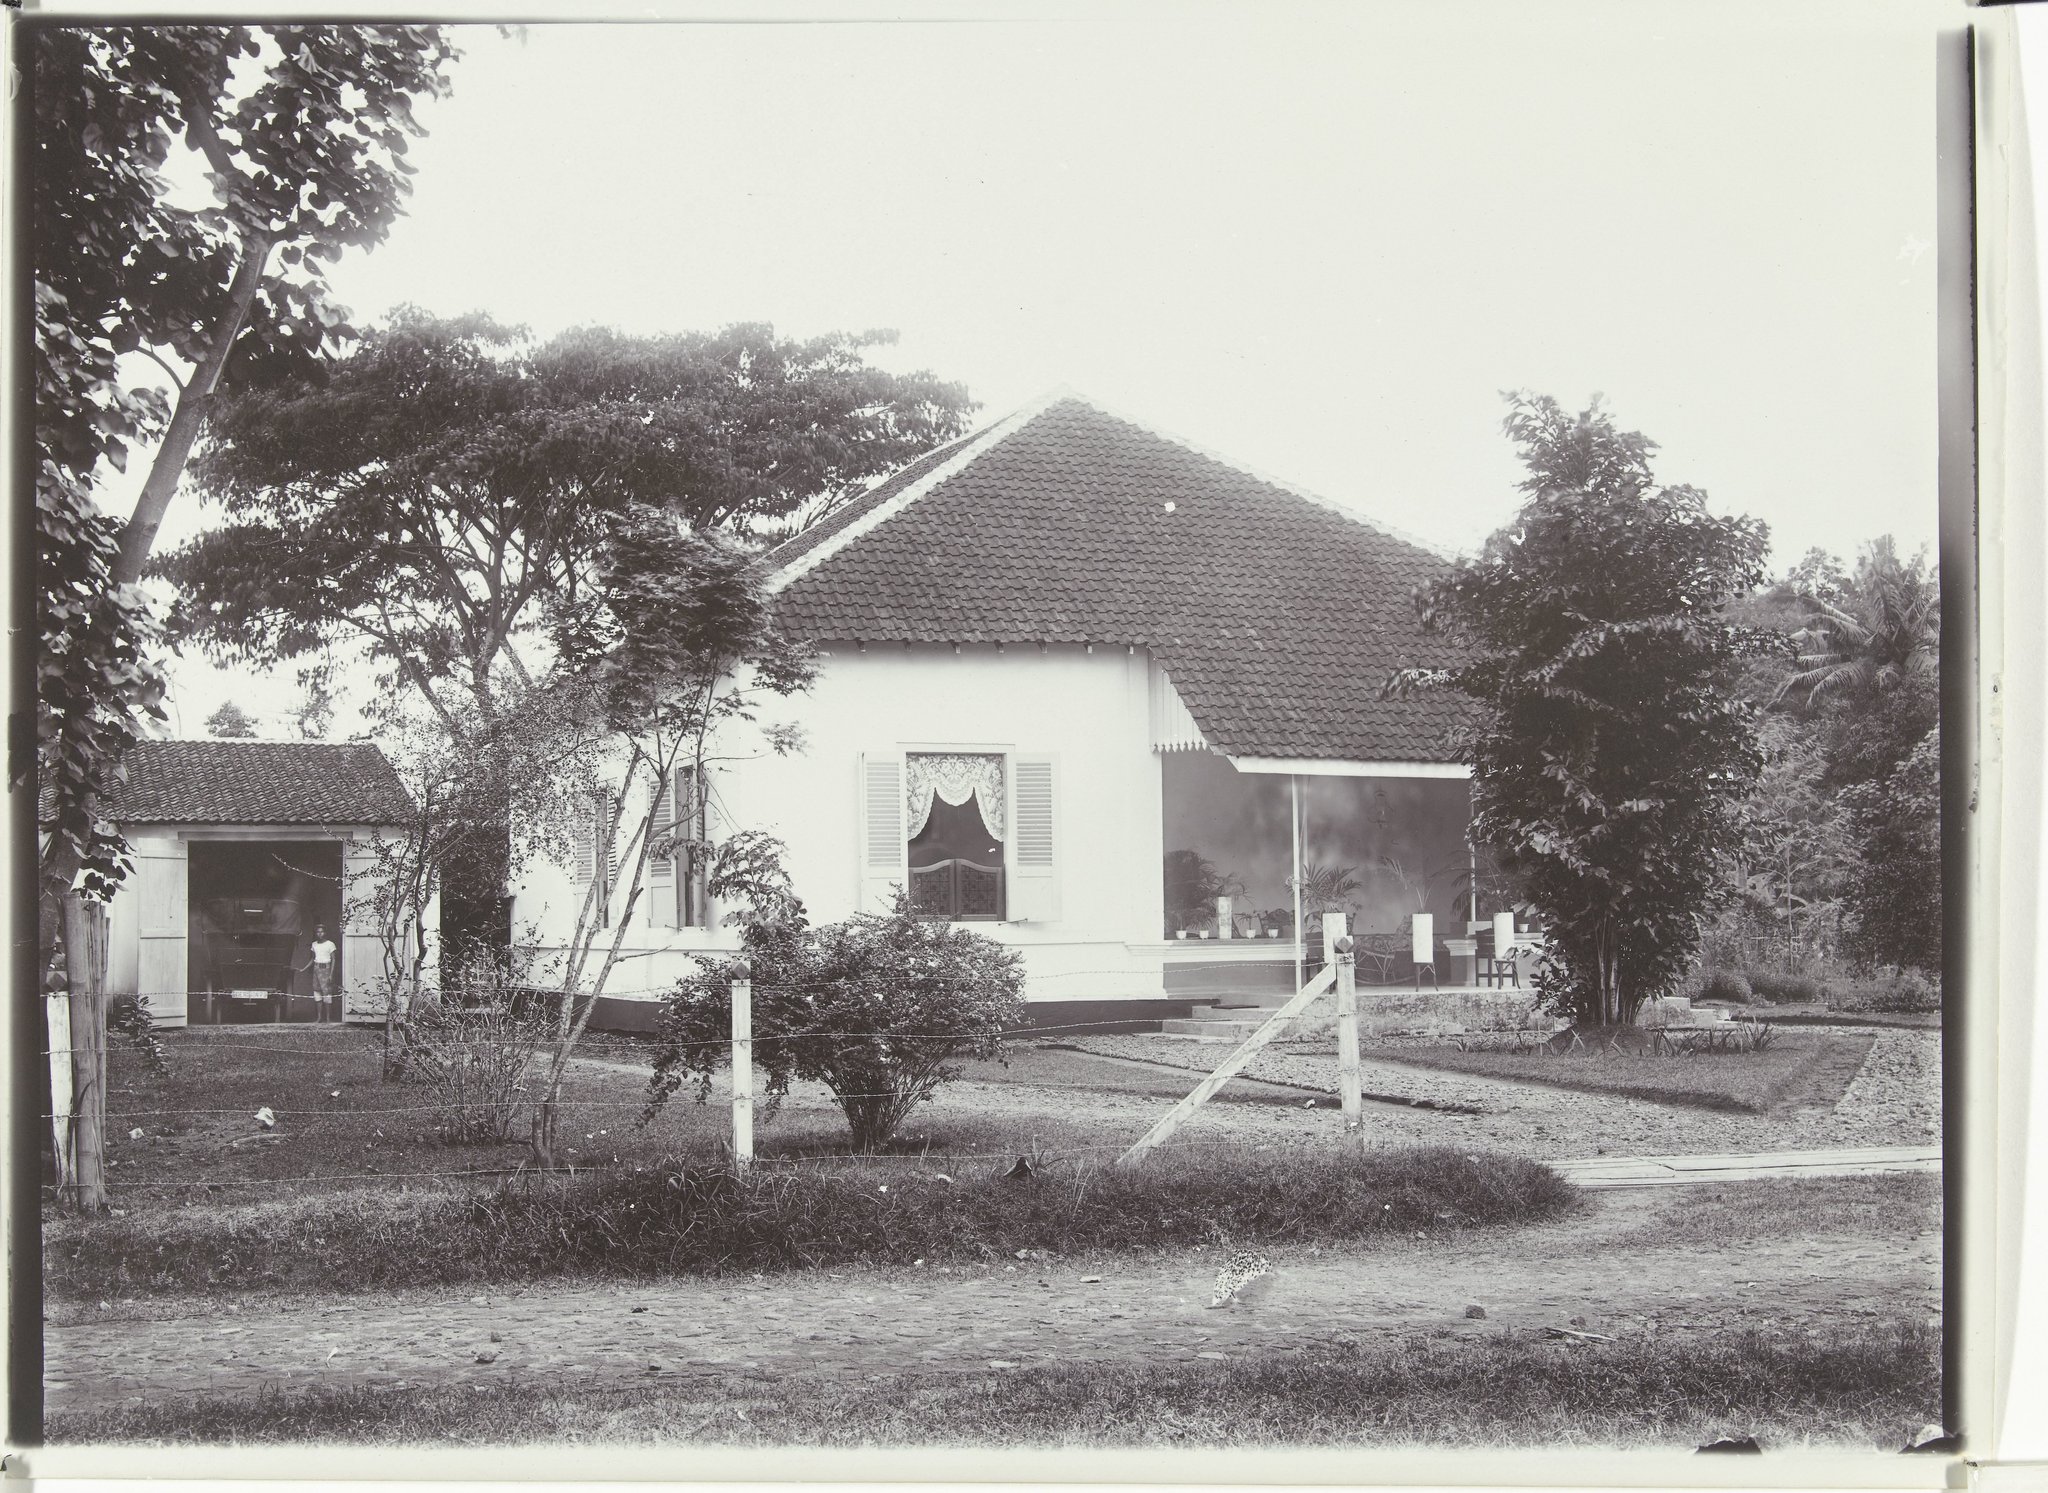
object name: photograph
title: Groot huis op de suikeronderneming Nieuw Tersana, Cheribon, voormalig Nederlands-Indië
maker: onnes kurkdjian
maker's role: fotograaf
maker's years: 1851-1903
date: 1890-1935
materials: paper, photographic support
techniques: gelatin silver print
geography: cirebon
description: Groot huis op de suikeronderneming Nieuw Tersana, Cheribon, voormalig Nederlands-Indië. Links in de schuur een auto.